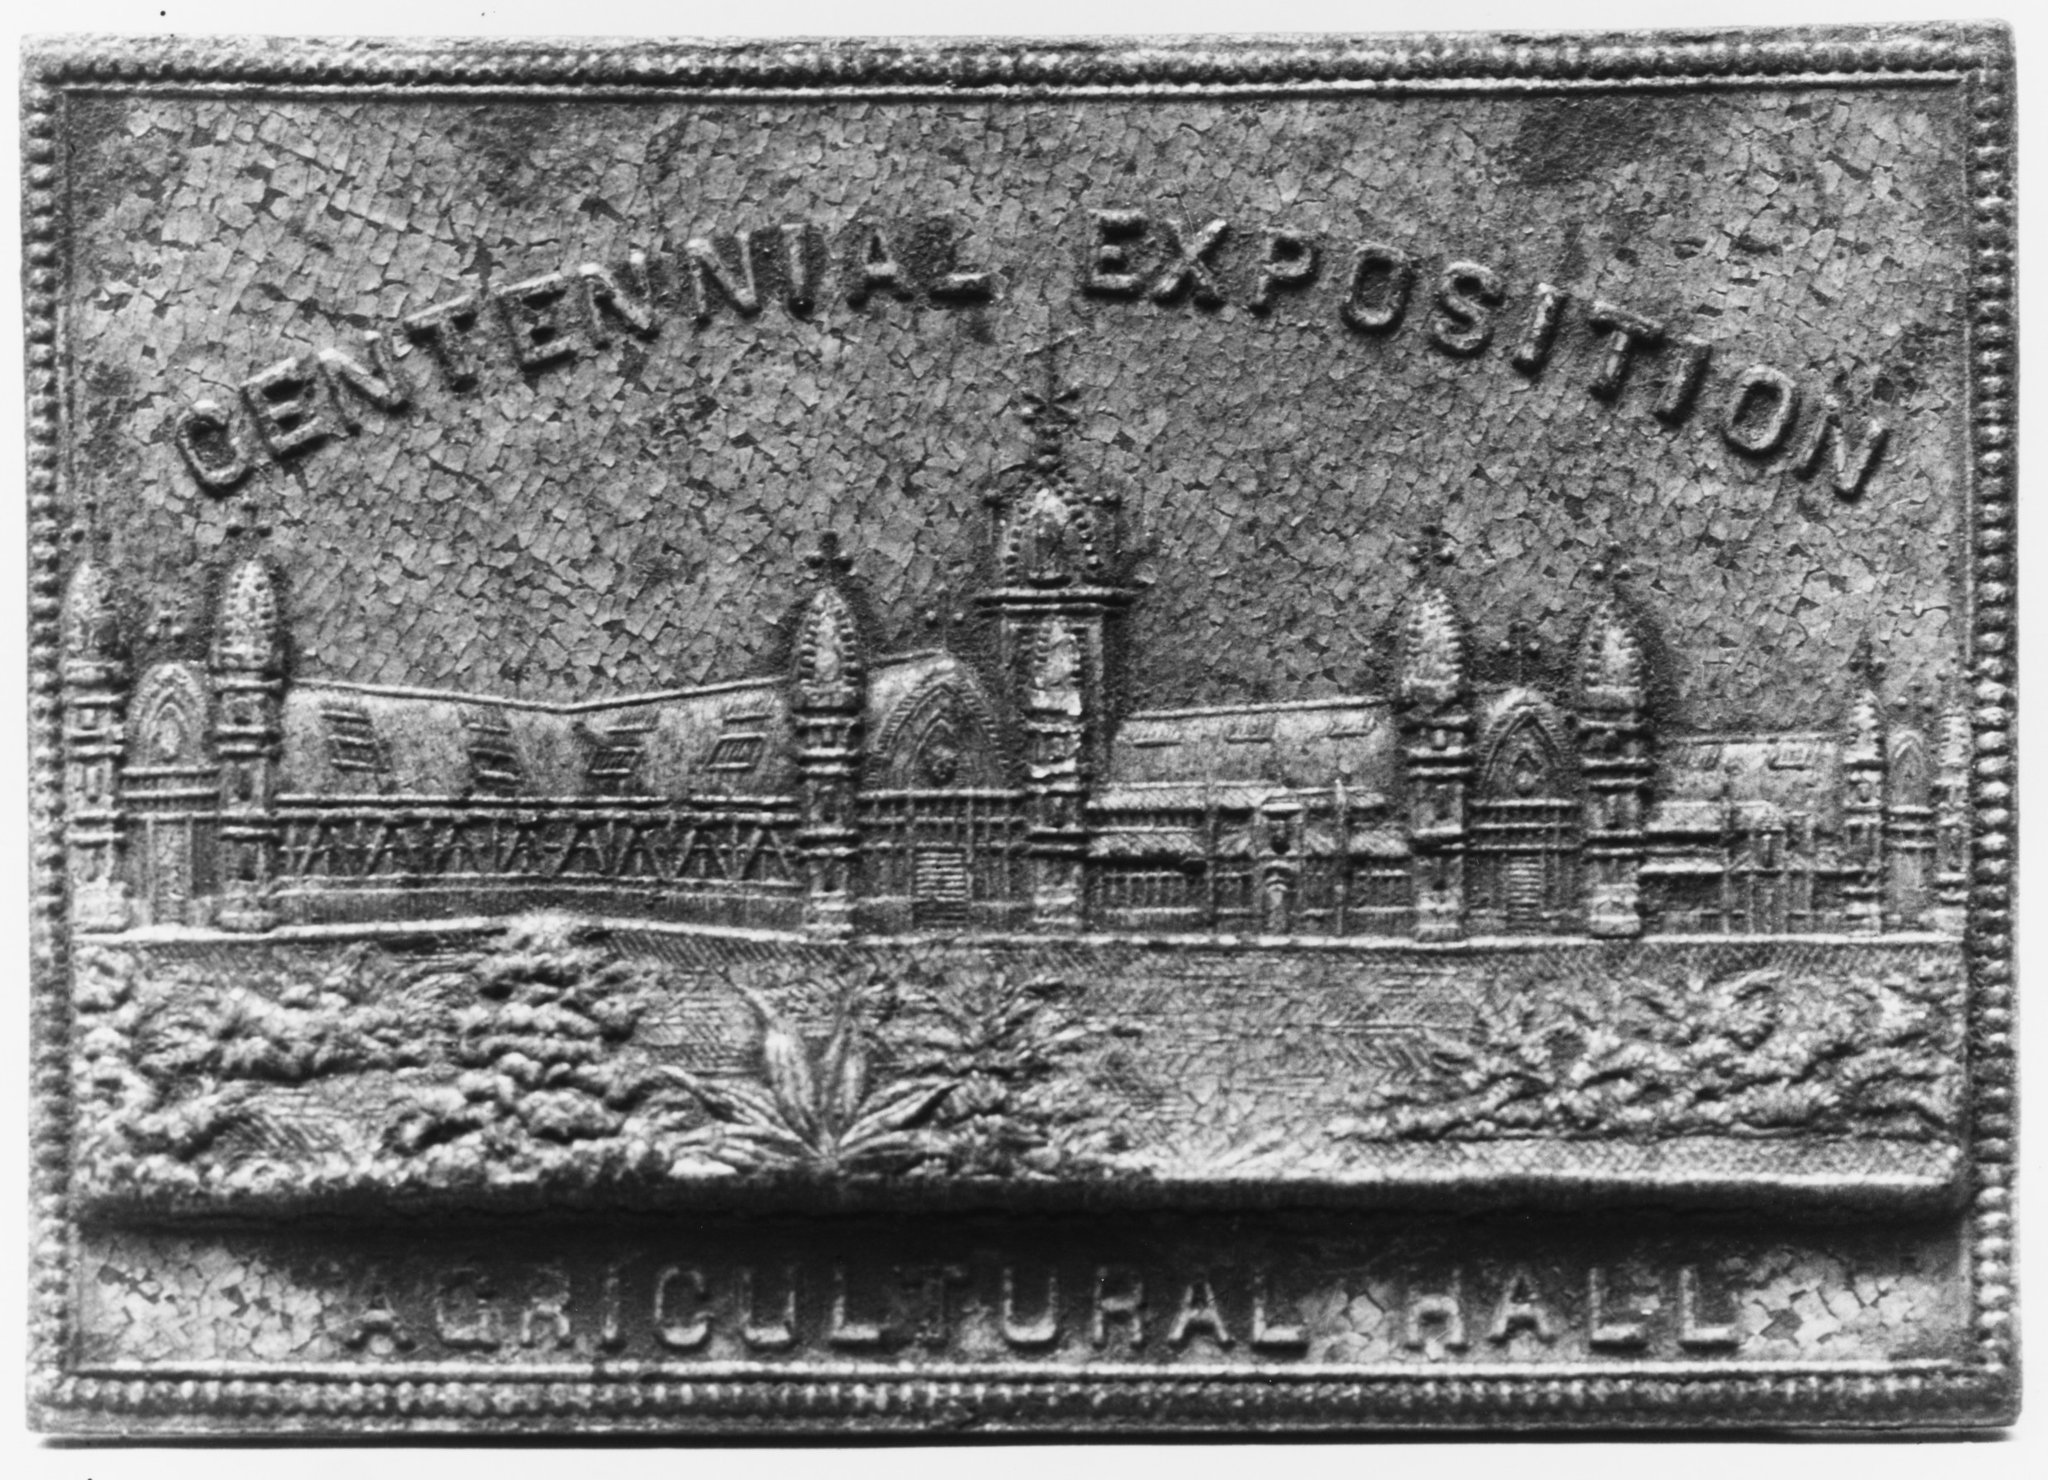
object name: plaque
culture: american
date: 1876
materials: wood